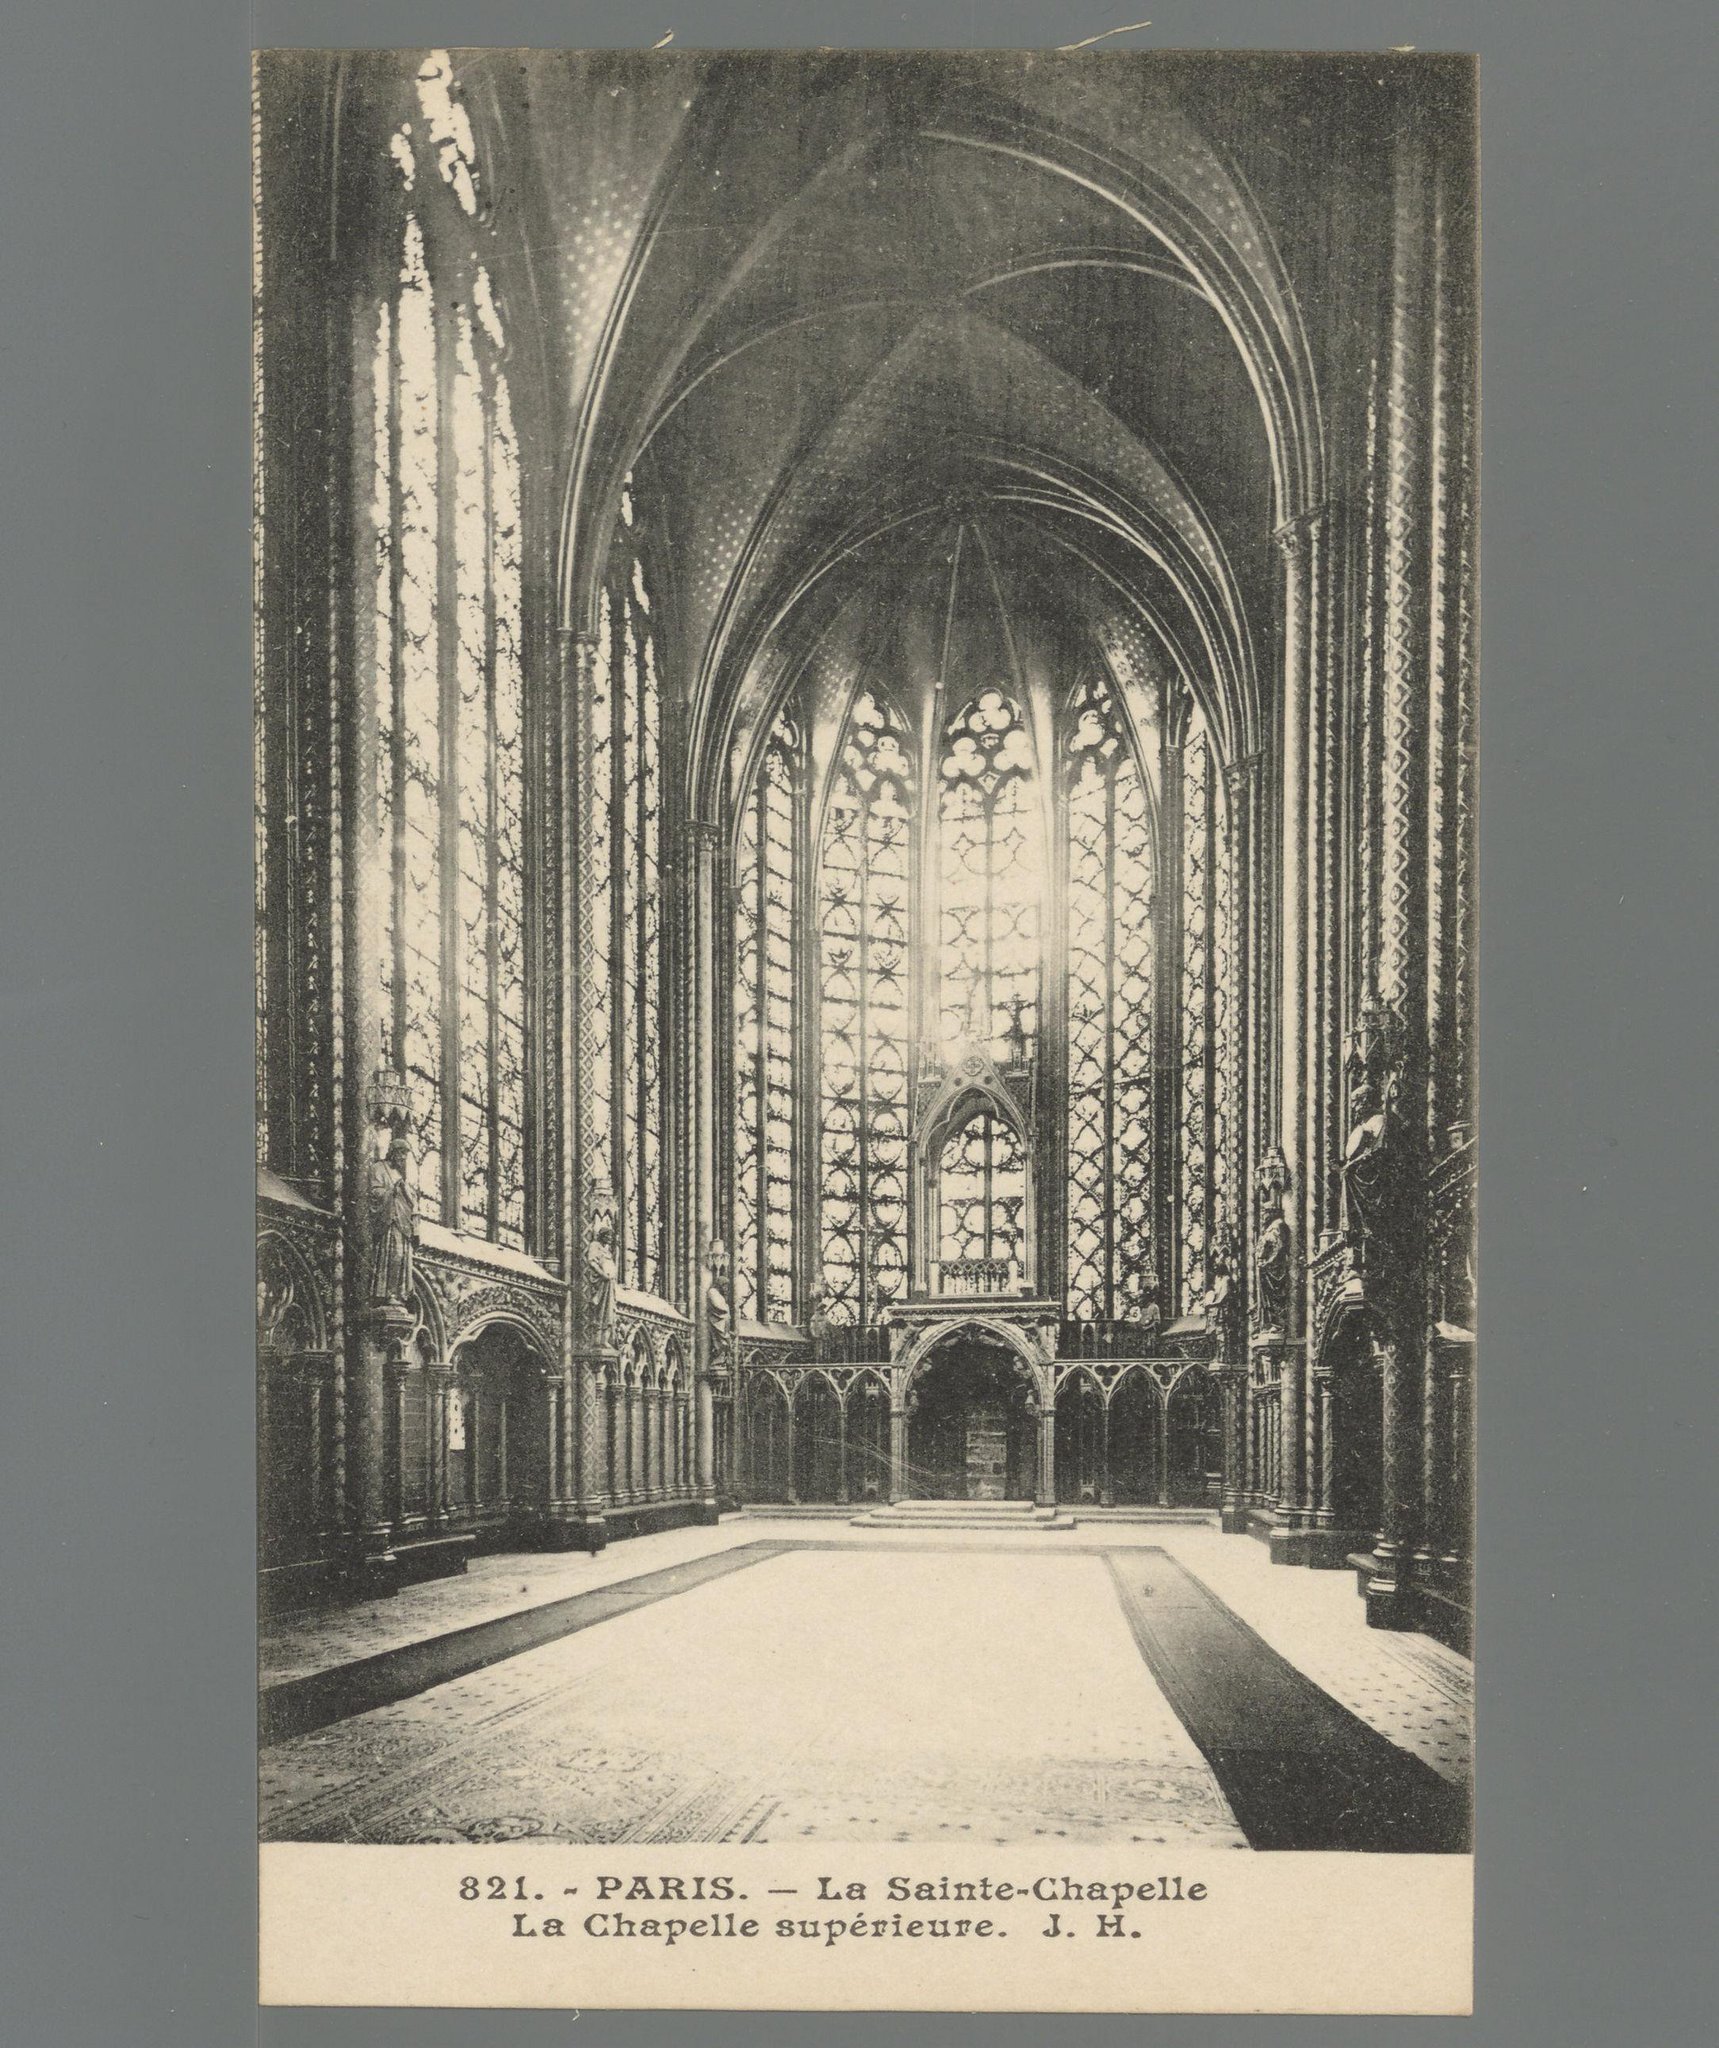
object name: photomechanical print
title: Paris - La Sainte-Chapelle. La Chapelle supérieure. J.H.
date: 1903-1930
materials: cardboard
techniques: photograph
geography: paris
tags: interior of church, church (exterior) - qq - small church, chapel